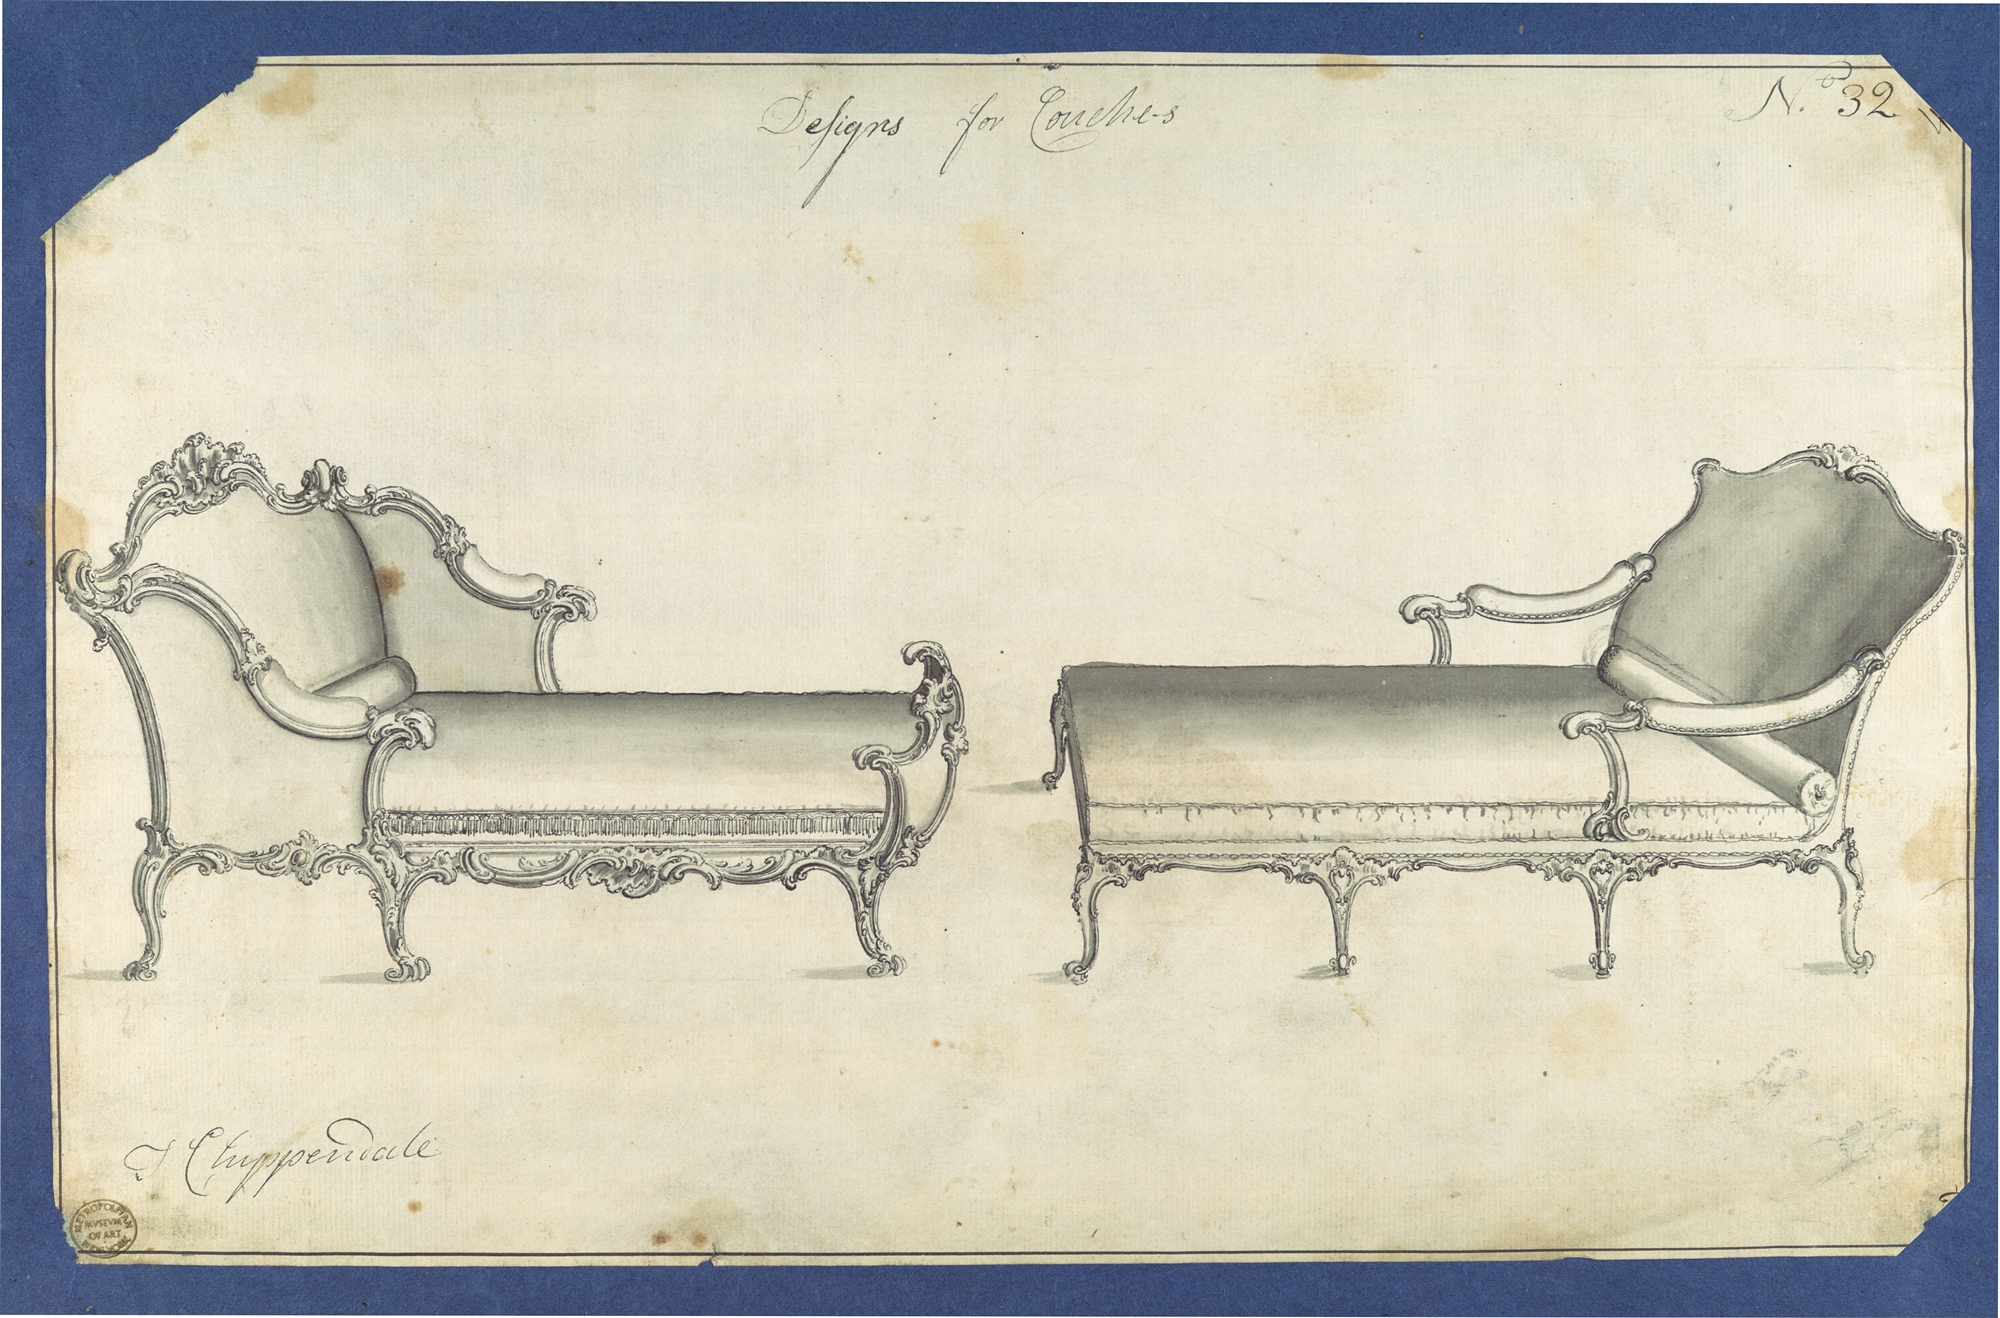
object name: drawing ornament architecture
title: Two Couches, in Chippendale Drawings, Vol. I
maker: thomas chippendale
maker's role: artist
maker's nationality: british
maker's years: 1718-1779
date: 1761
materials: ink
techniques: wash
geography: london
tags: couches